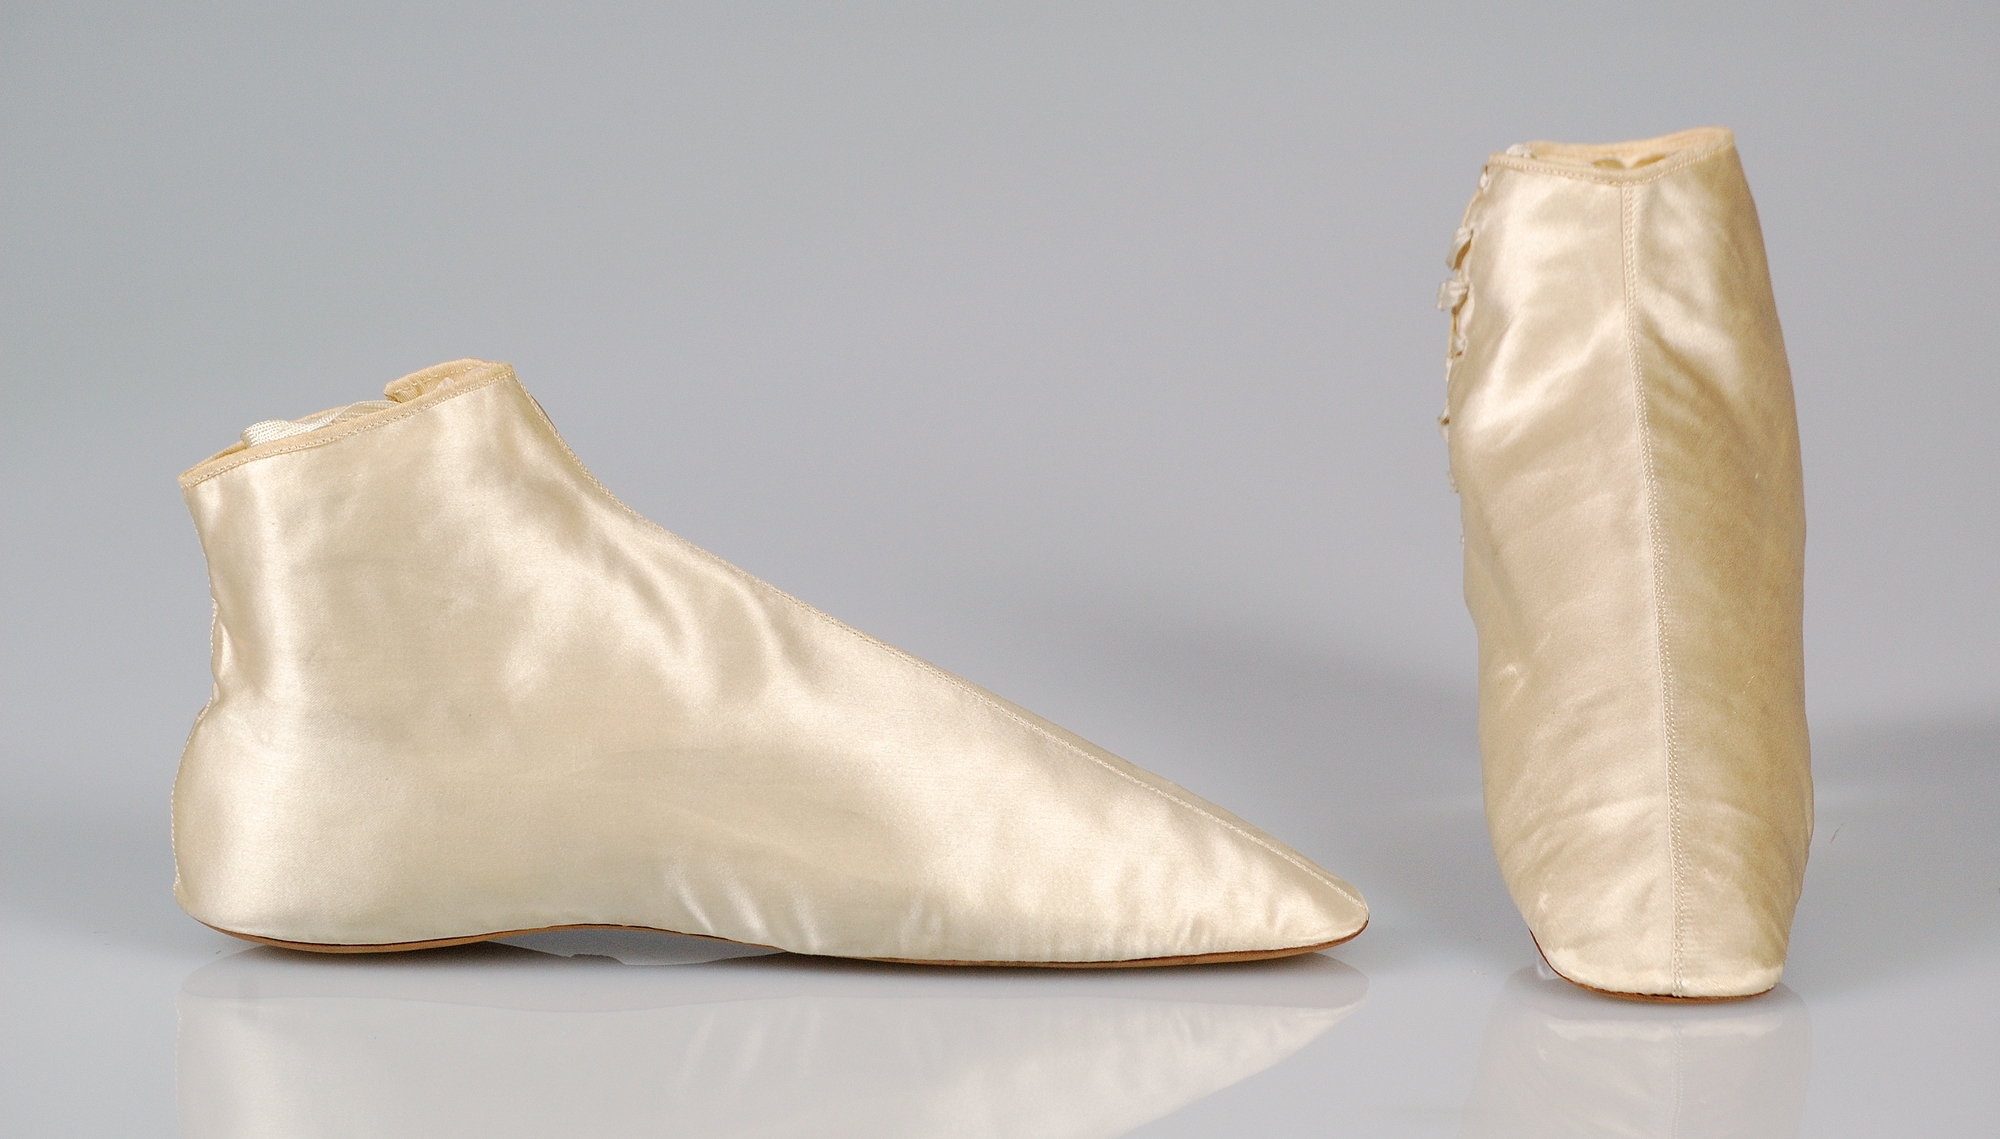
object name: wedding boot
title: Wedding boots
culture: french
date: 1854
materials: silk